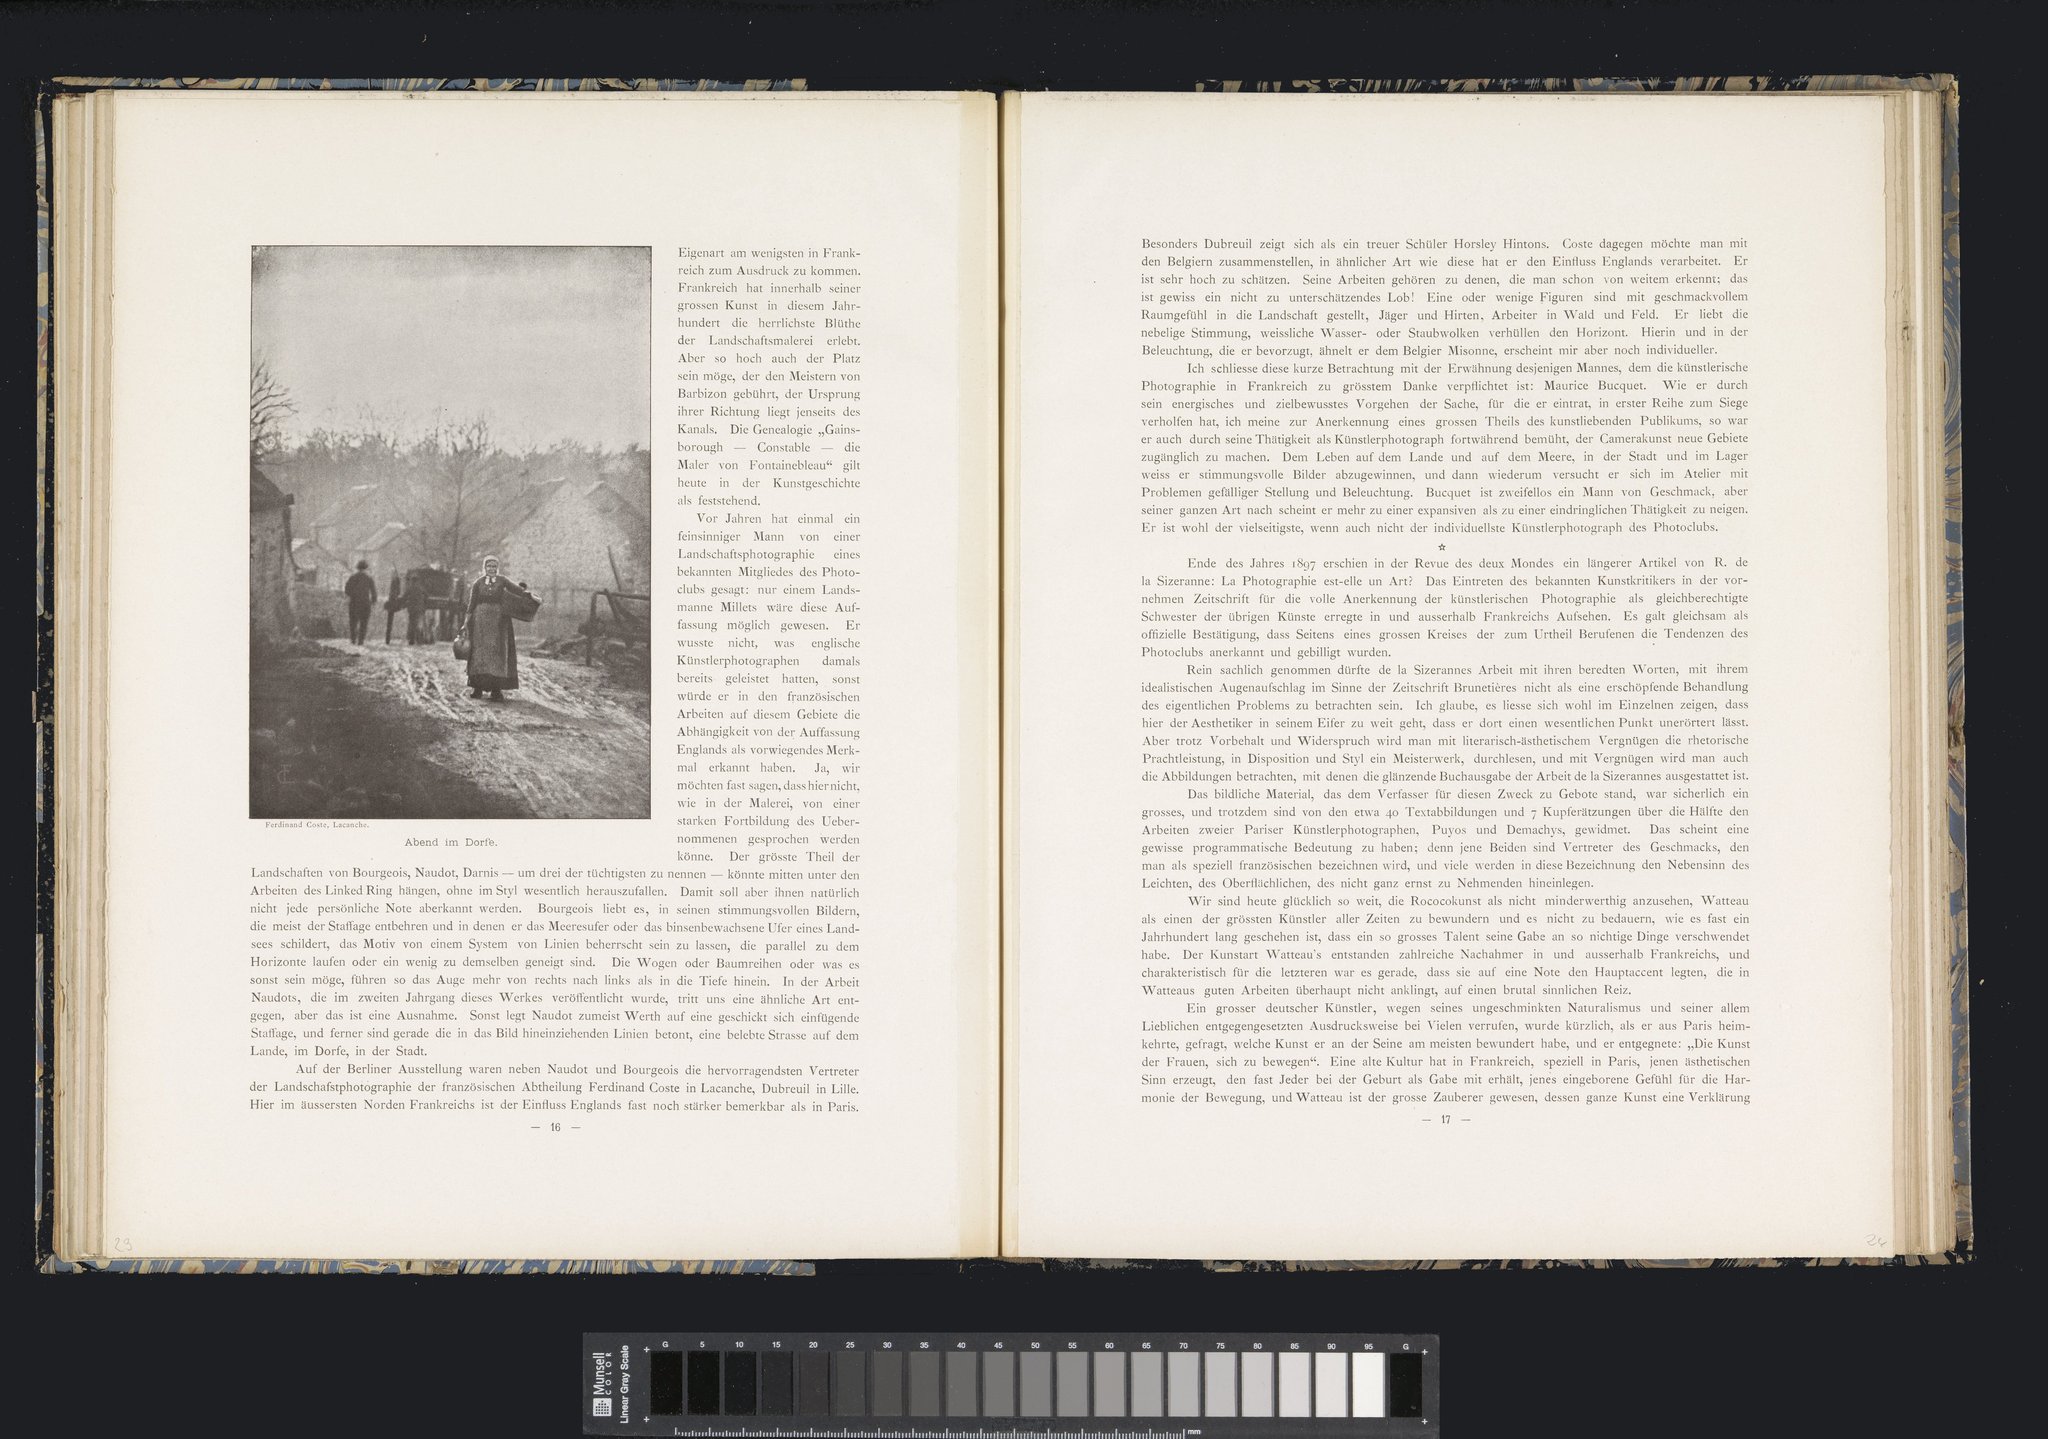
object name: page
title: Abend im Dorfe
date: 1889-1899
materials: paper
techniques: autotype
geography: france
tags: adult woman, public road in village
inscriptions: inscription: ‘Bx’